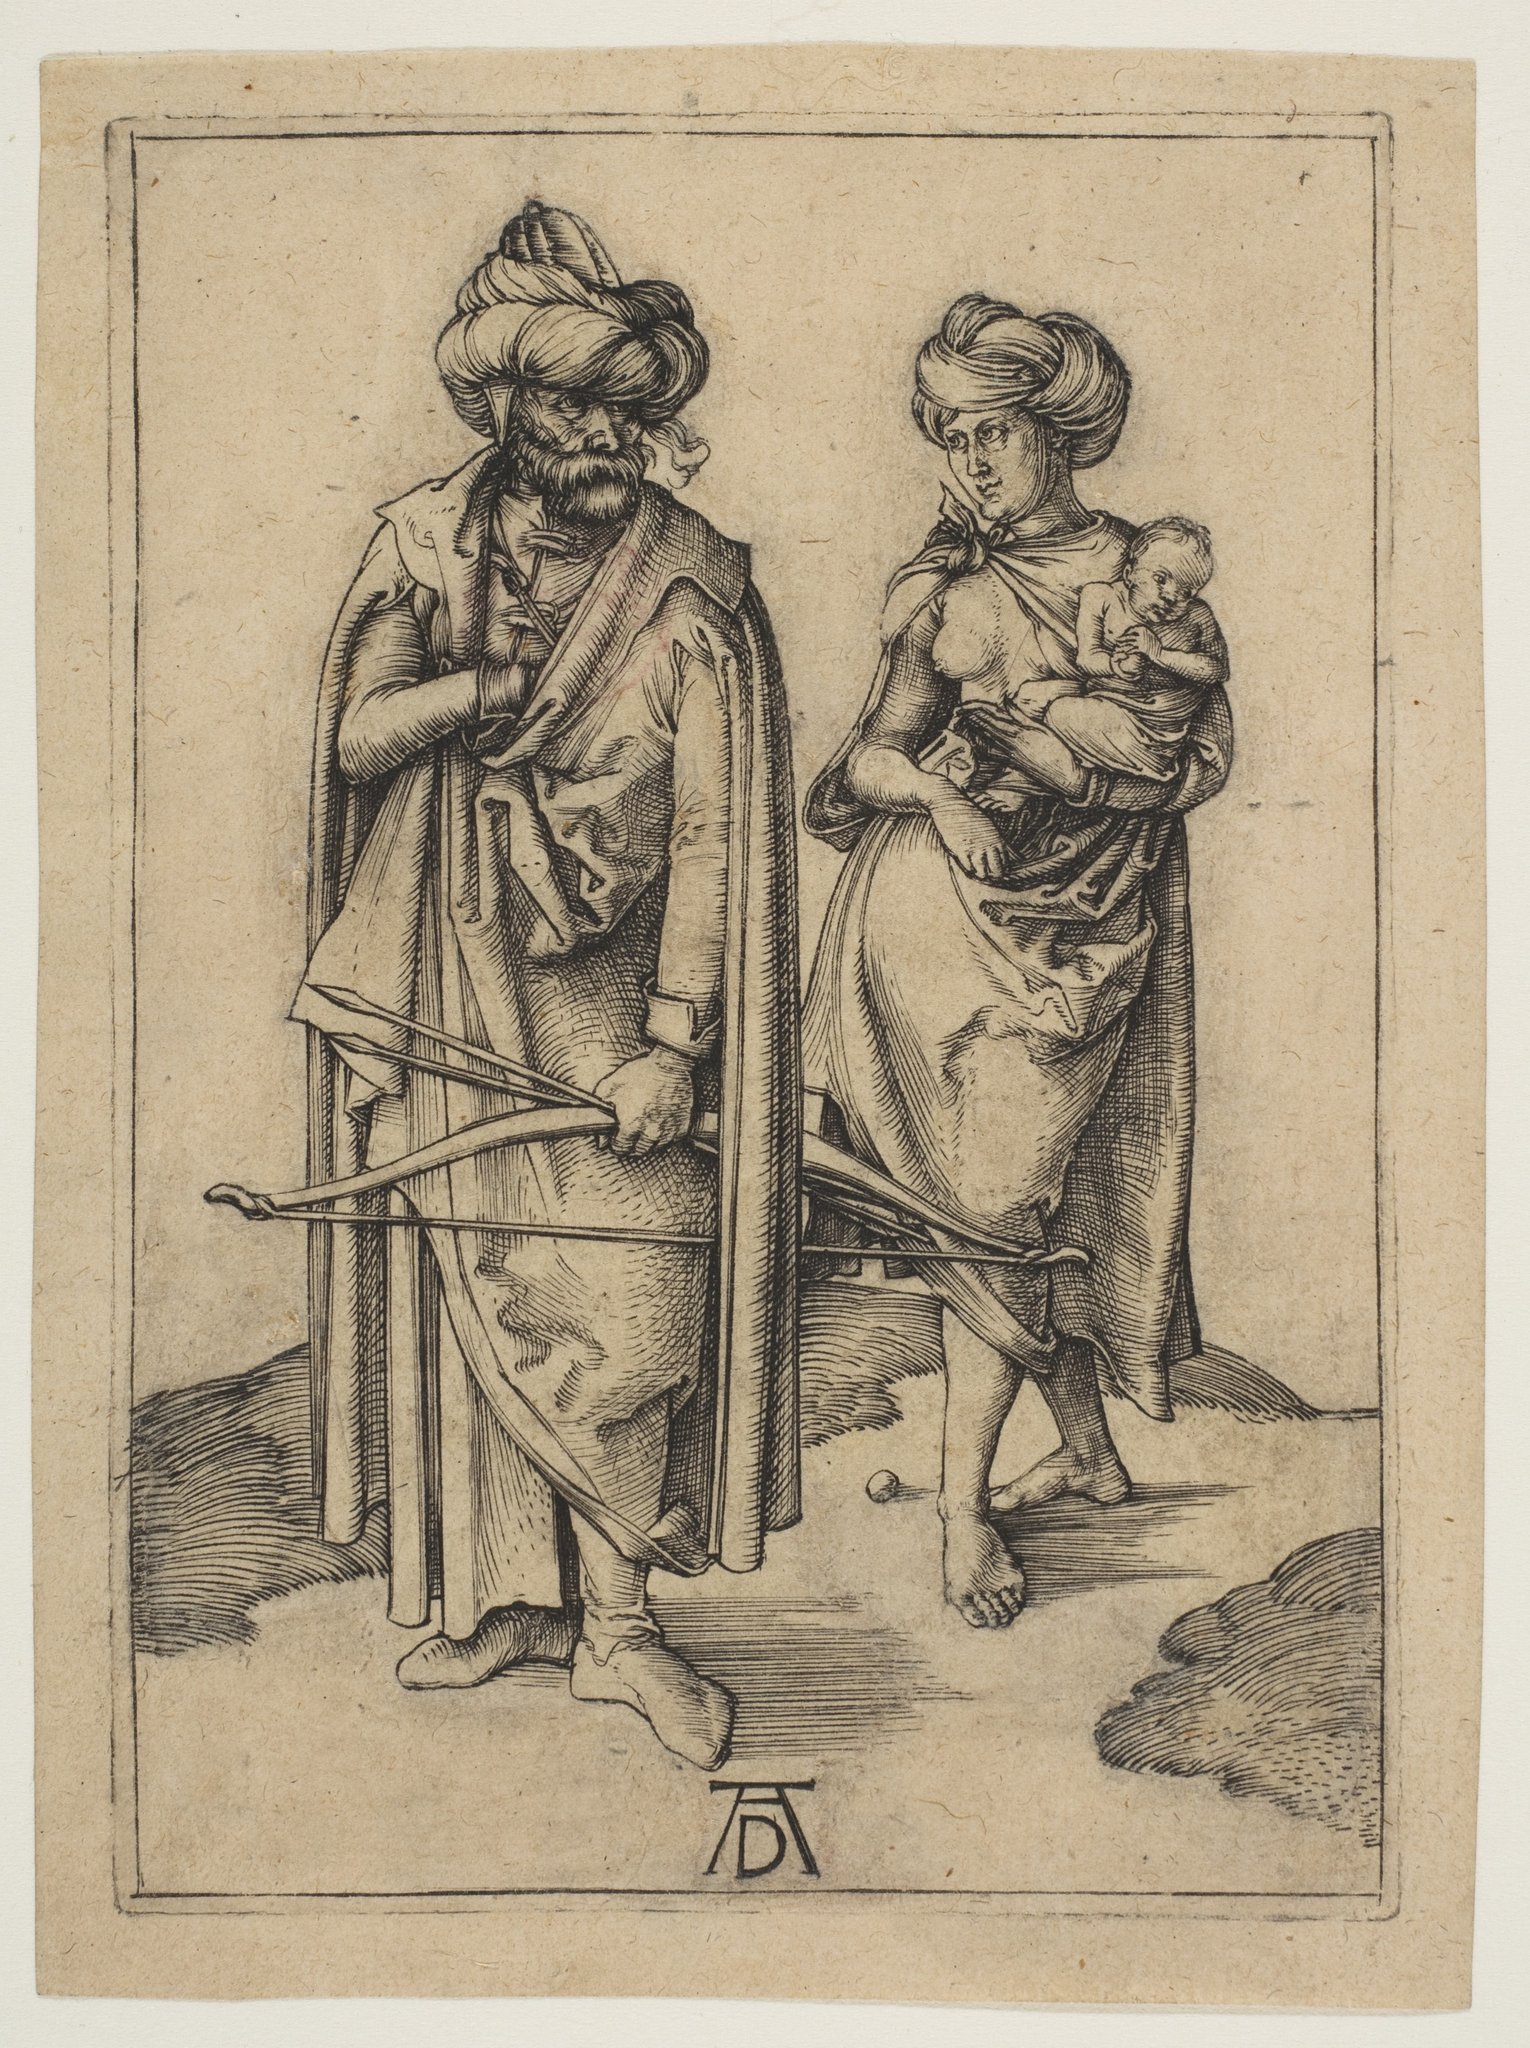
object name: print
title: Turkish Family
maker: albrecht dürer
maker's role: artist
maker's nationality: german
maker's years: 1471-1528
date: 1496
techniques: engraving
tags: bow and arrow,infants,fathers,mothers,family